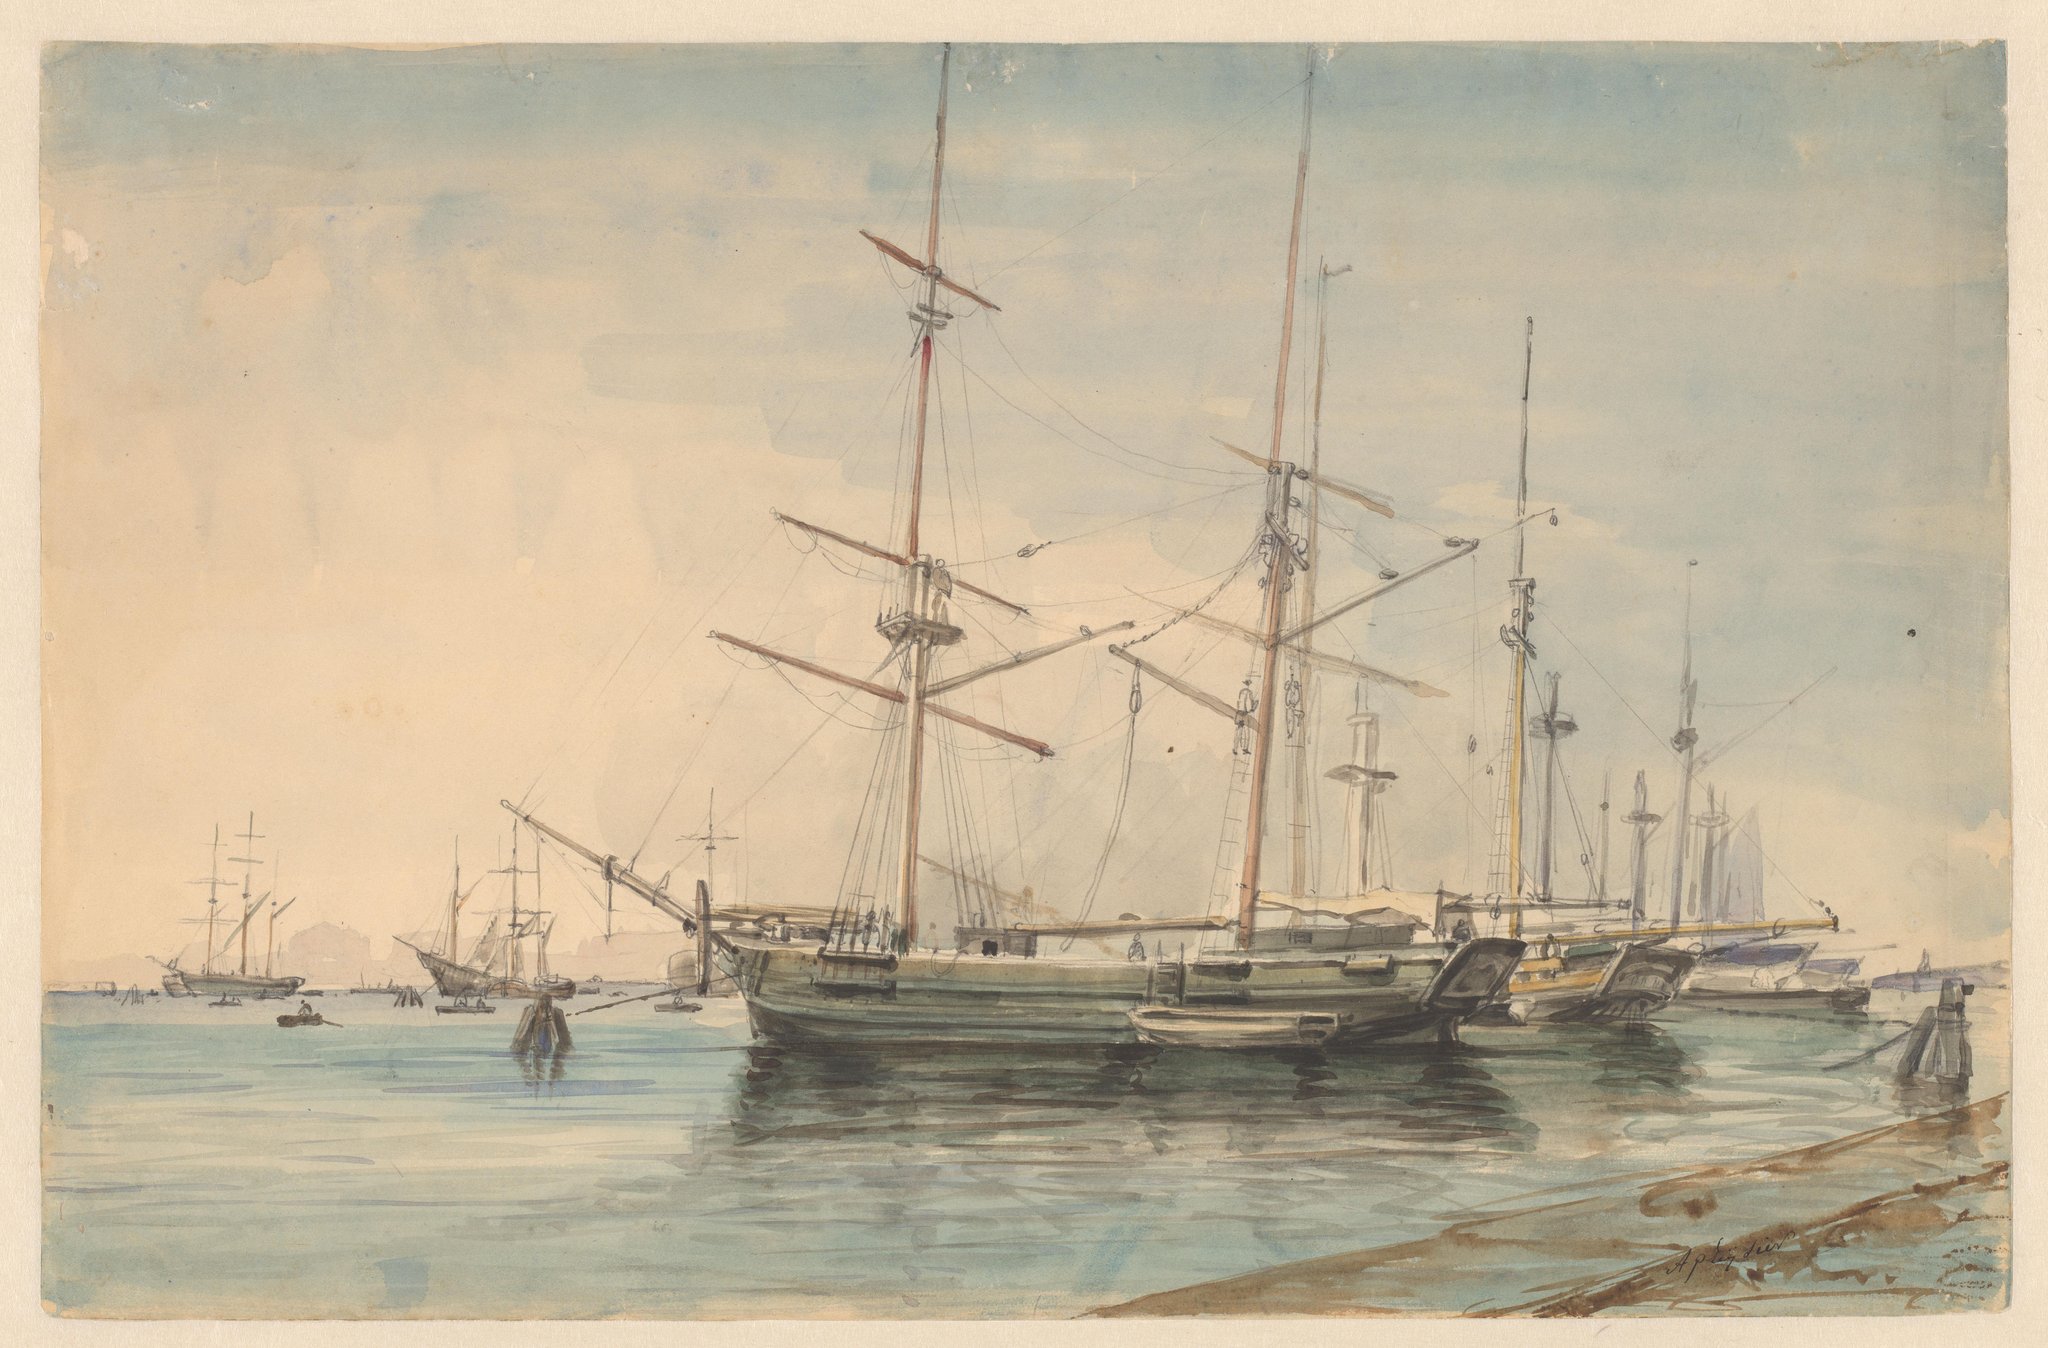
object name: drawing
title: Zeilschepen in een haven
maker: ary pleijsier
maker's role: draughtsman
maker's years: 1819-1879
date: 1829-1879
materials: paper, pencil, watercolor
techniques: brush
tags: harbour, sailing-ship, sailing-boat